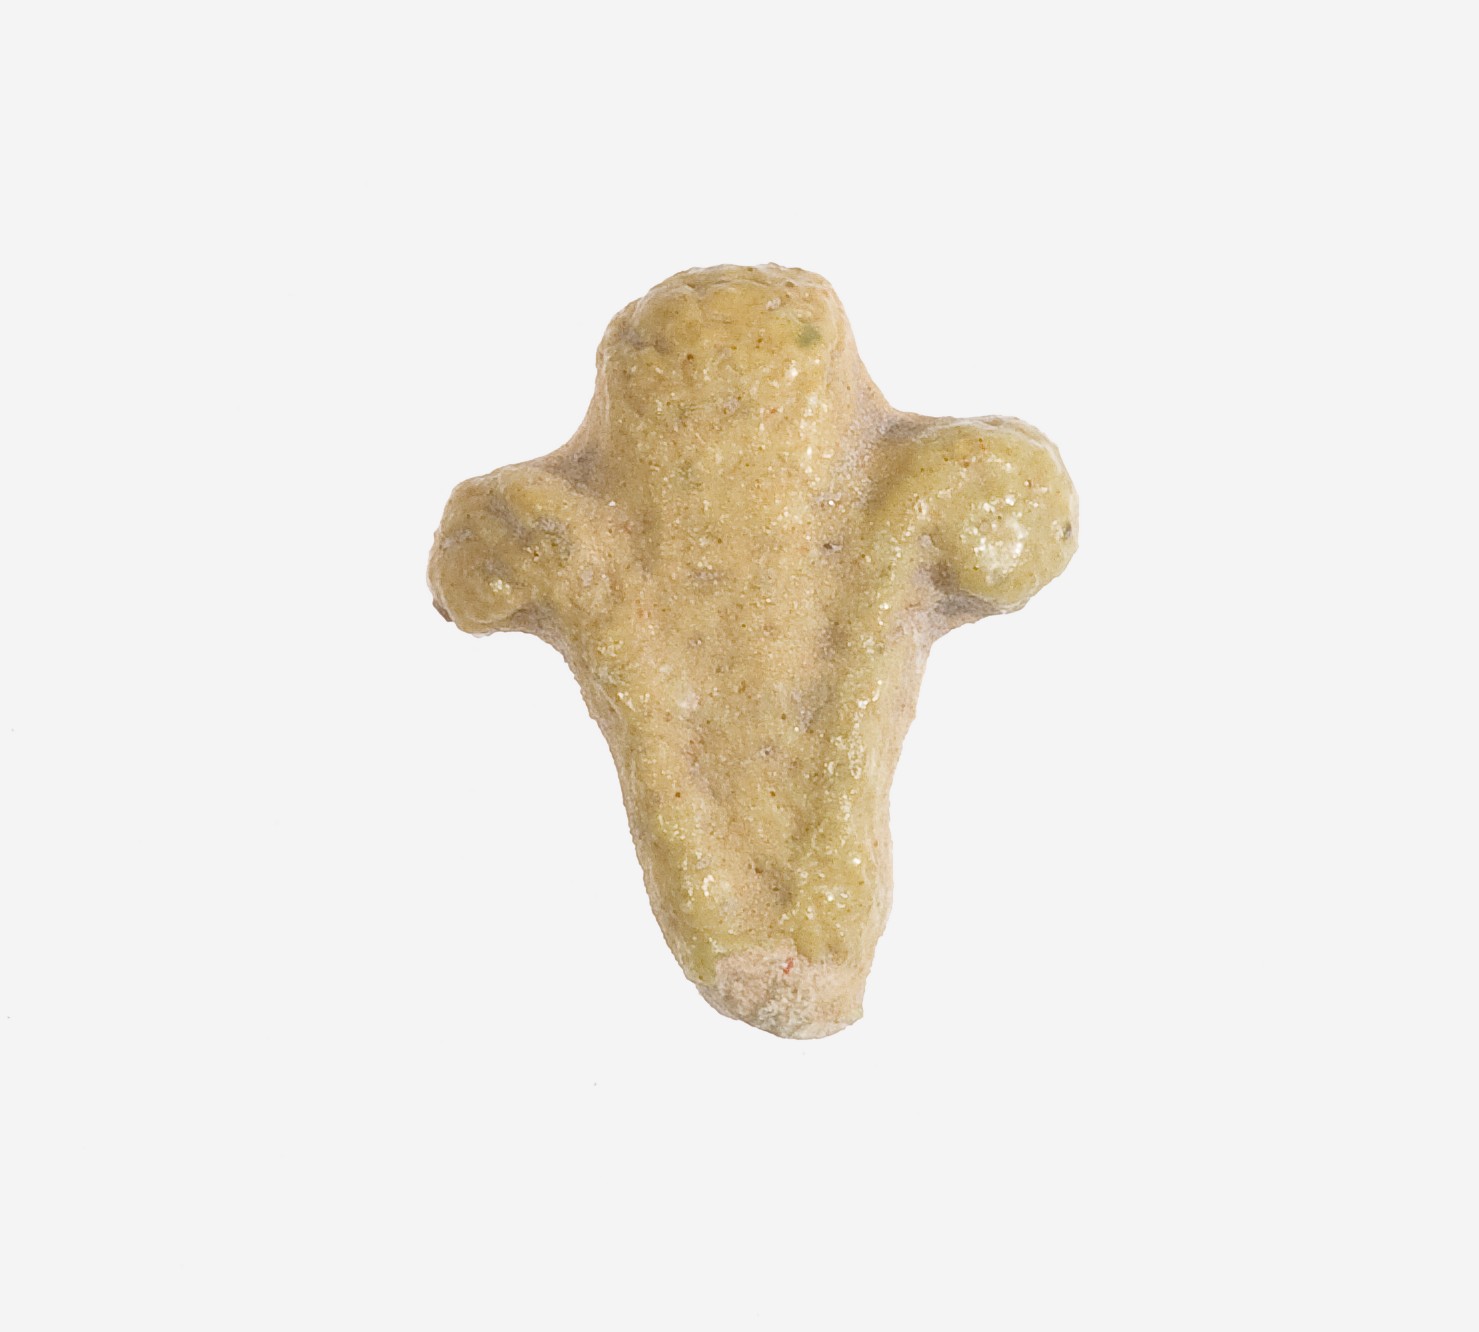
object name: pendant, lily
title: Lily Pendant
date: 1390-1352 BCE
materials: faience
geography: egypt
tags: lilies